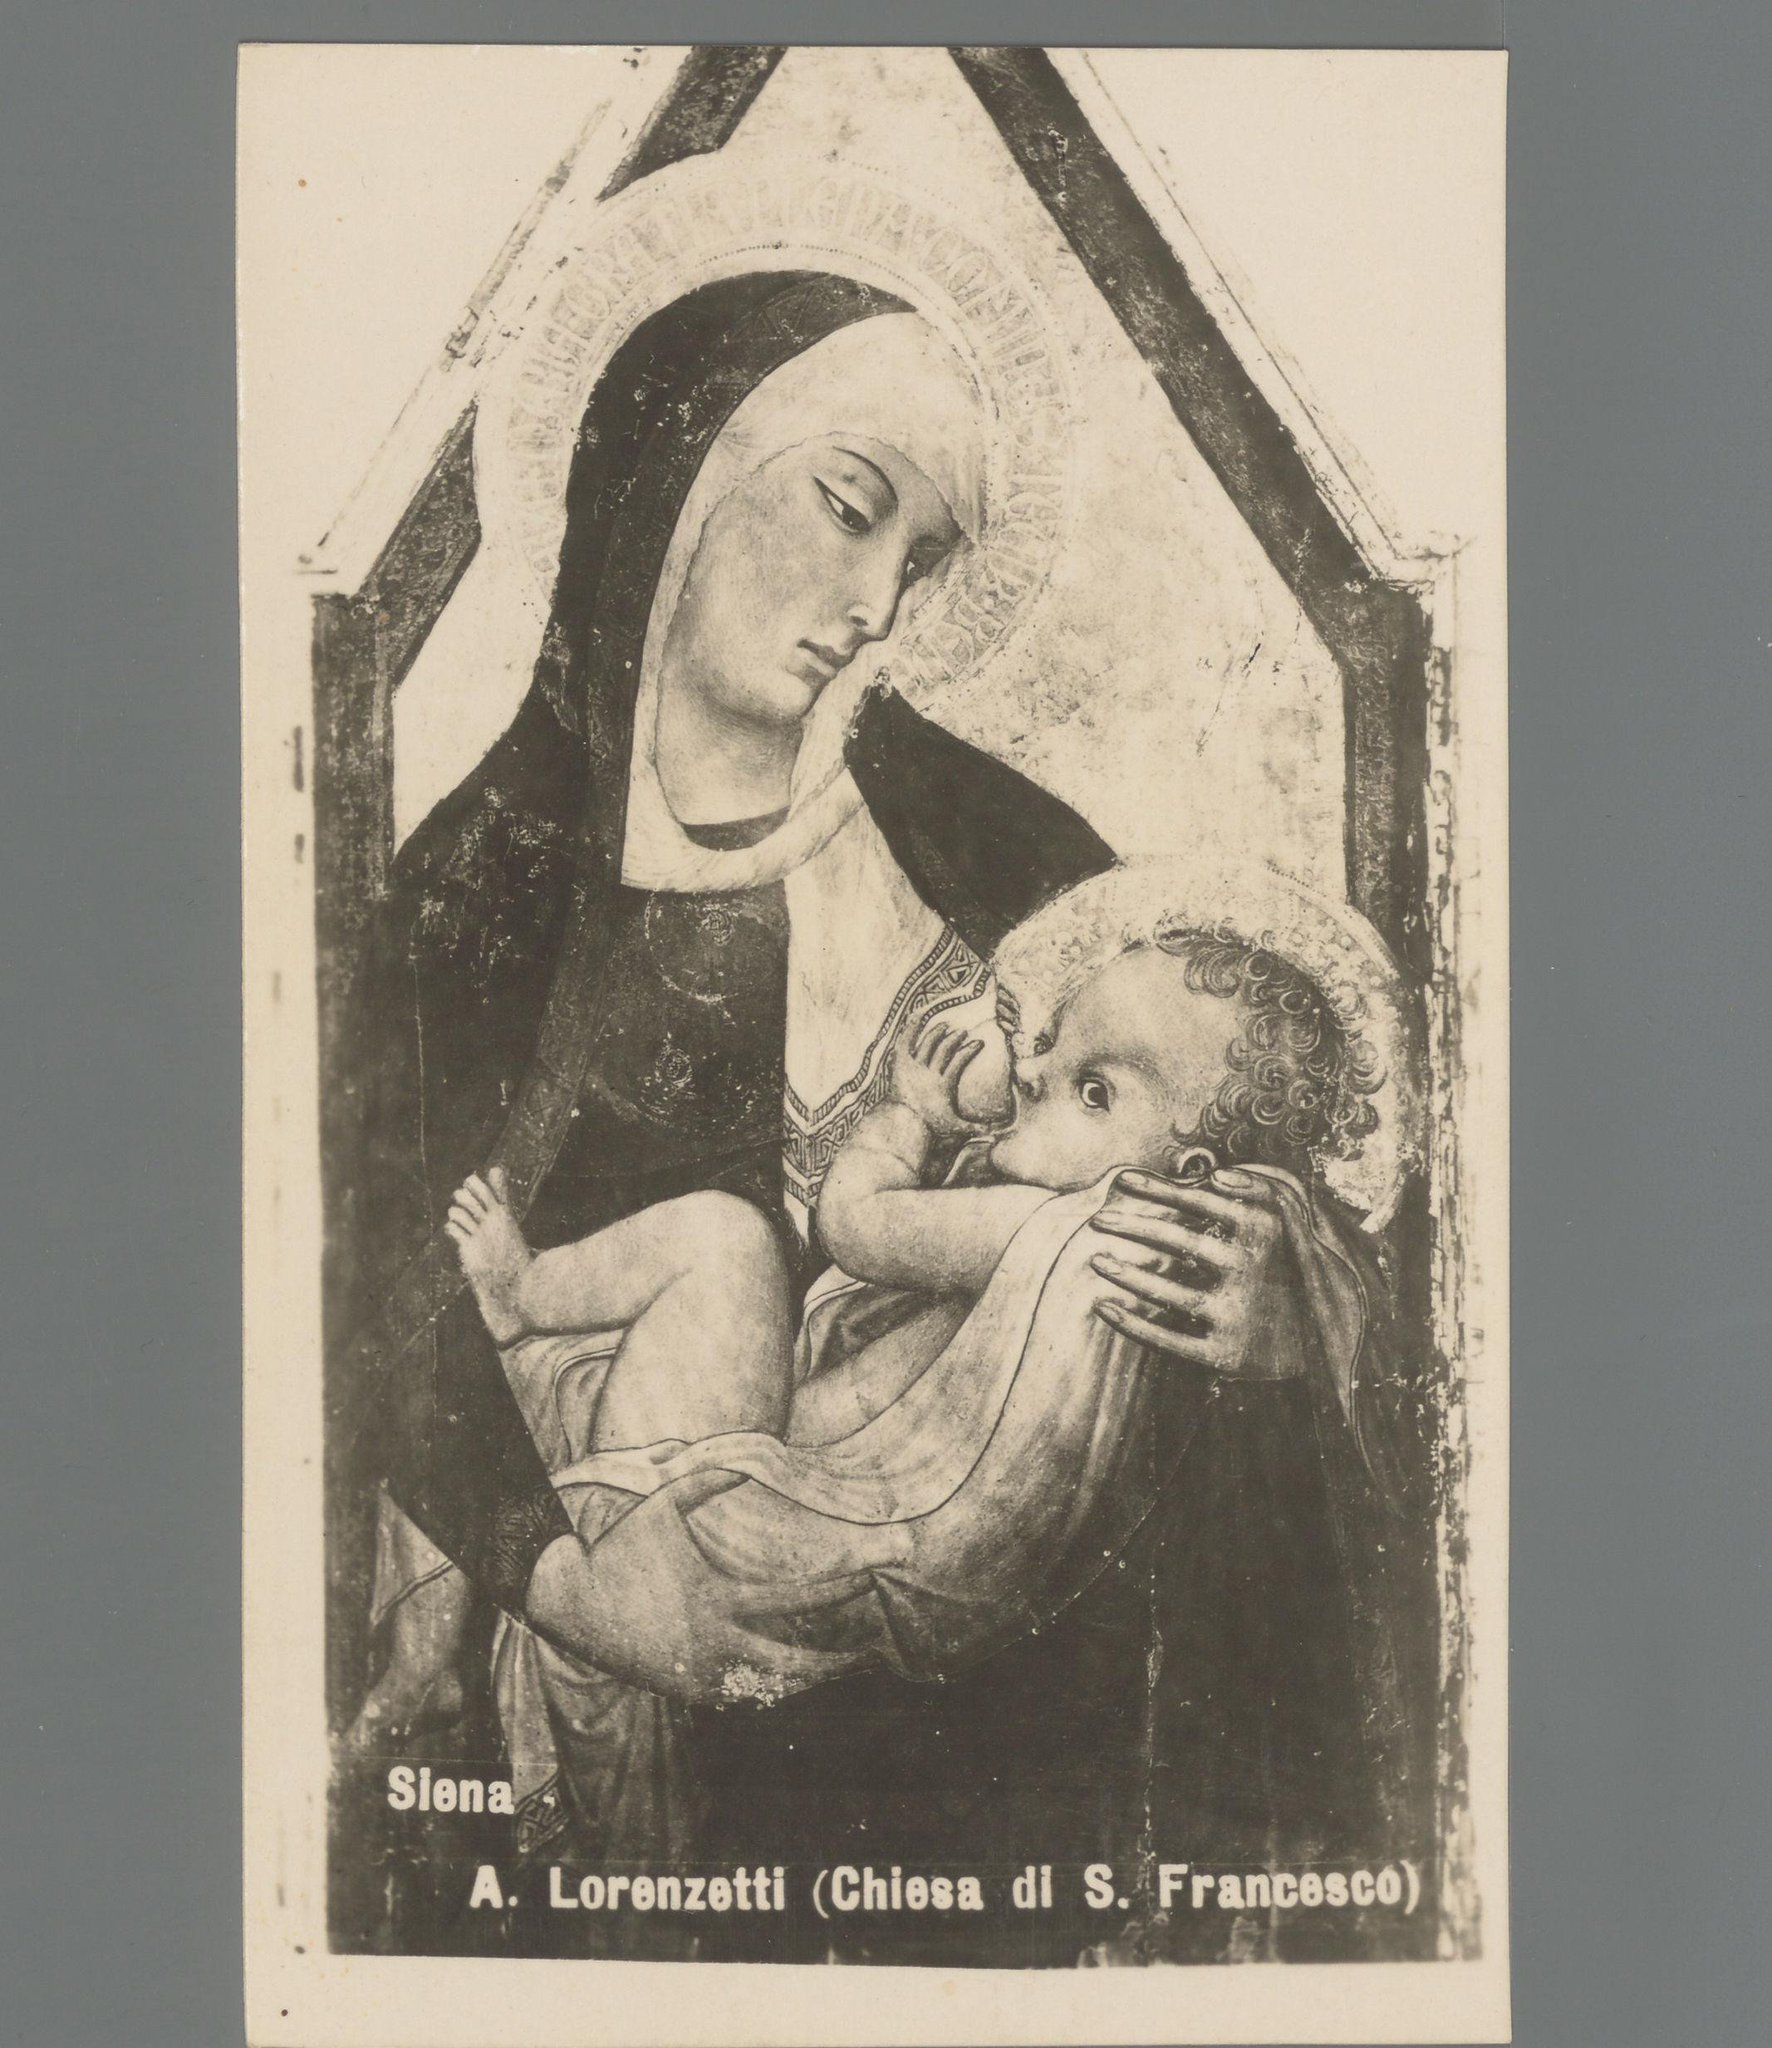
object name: photograph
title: Siena. A. Lorenzetti (Chiesa di S. Francesco)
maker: Anonymous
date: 1906-1930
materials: paper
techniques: gelatin silver print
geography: siena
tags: interior of church, picture, painting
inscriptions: collector's mark: ‘AFE v S’